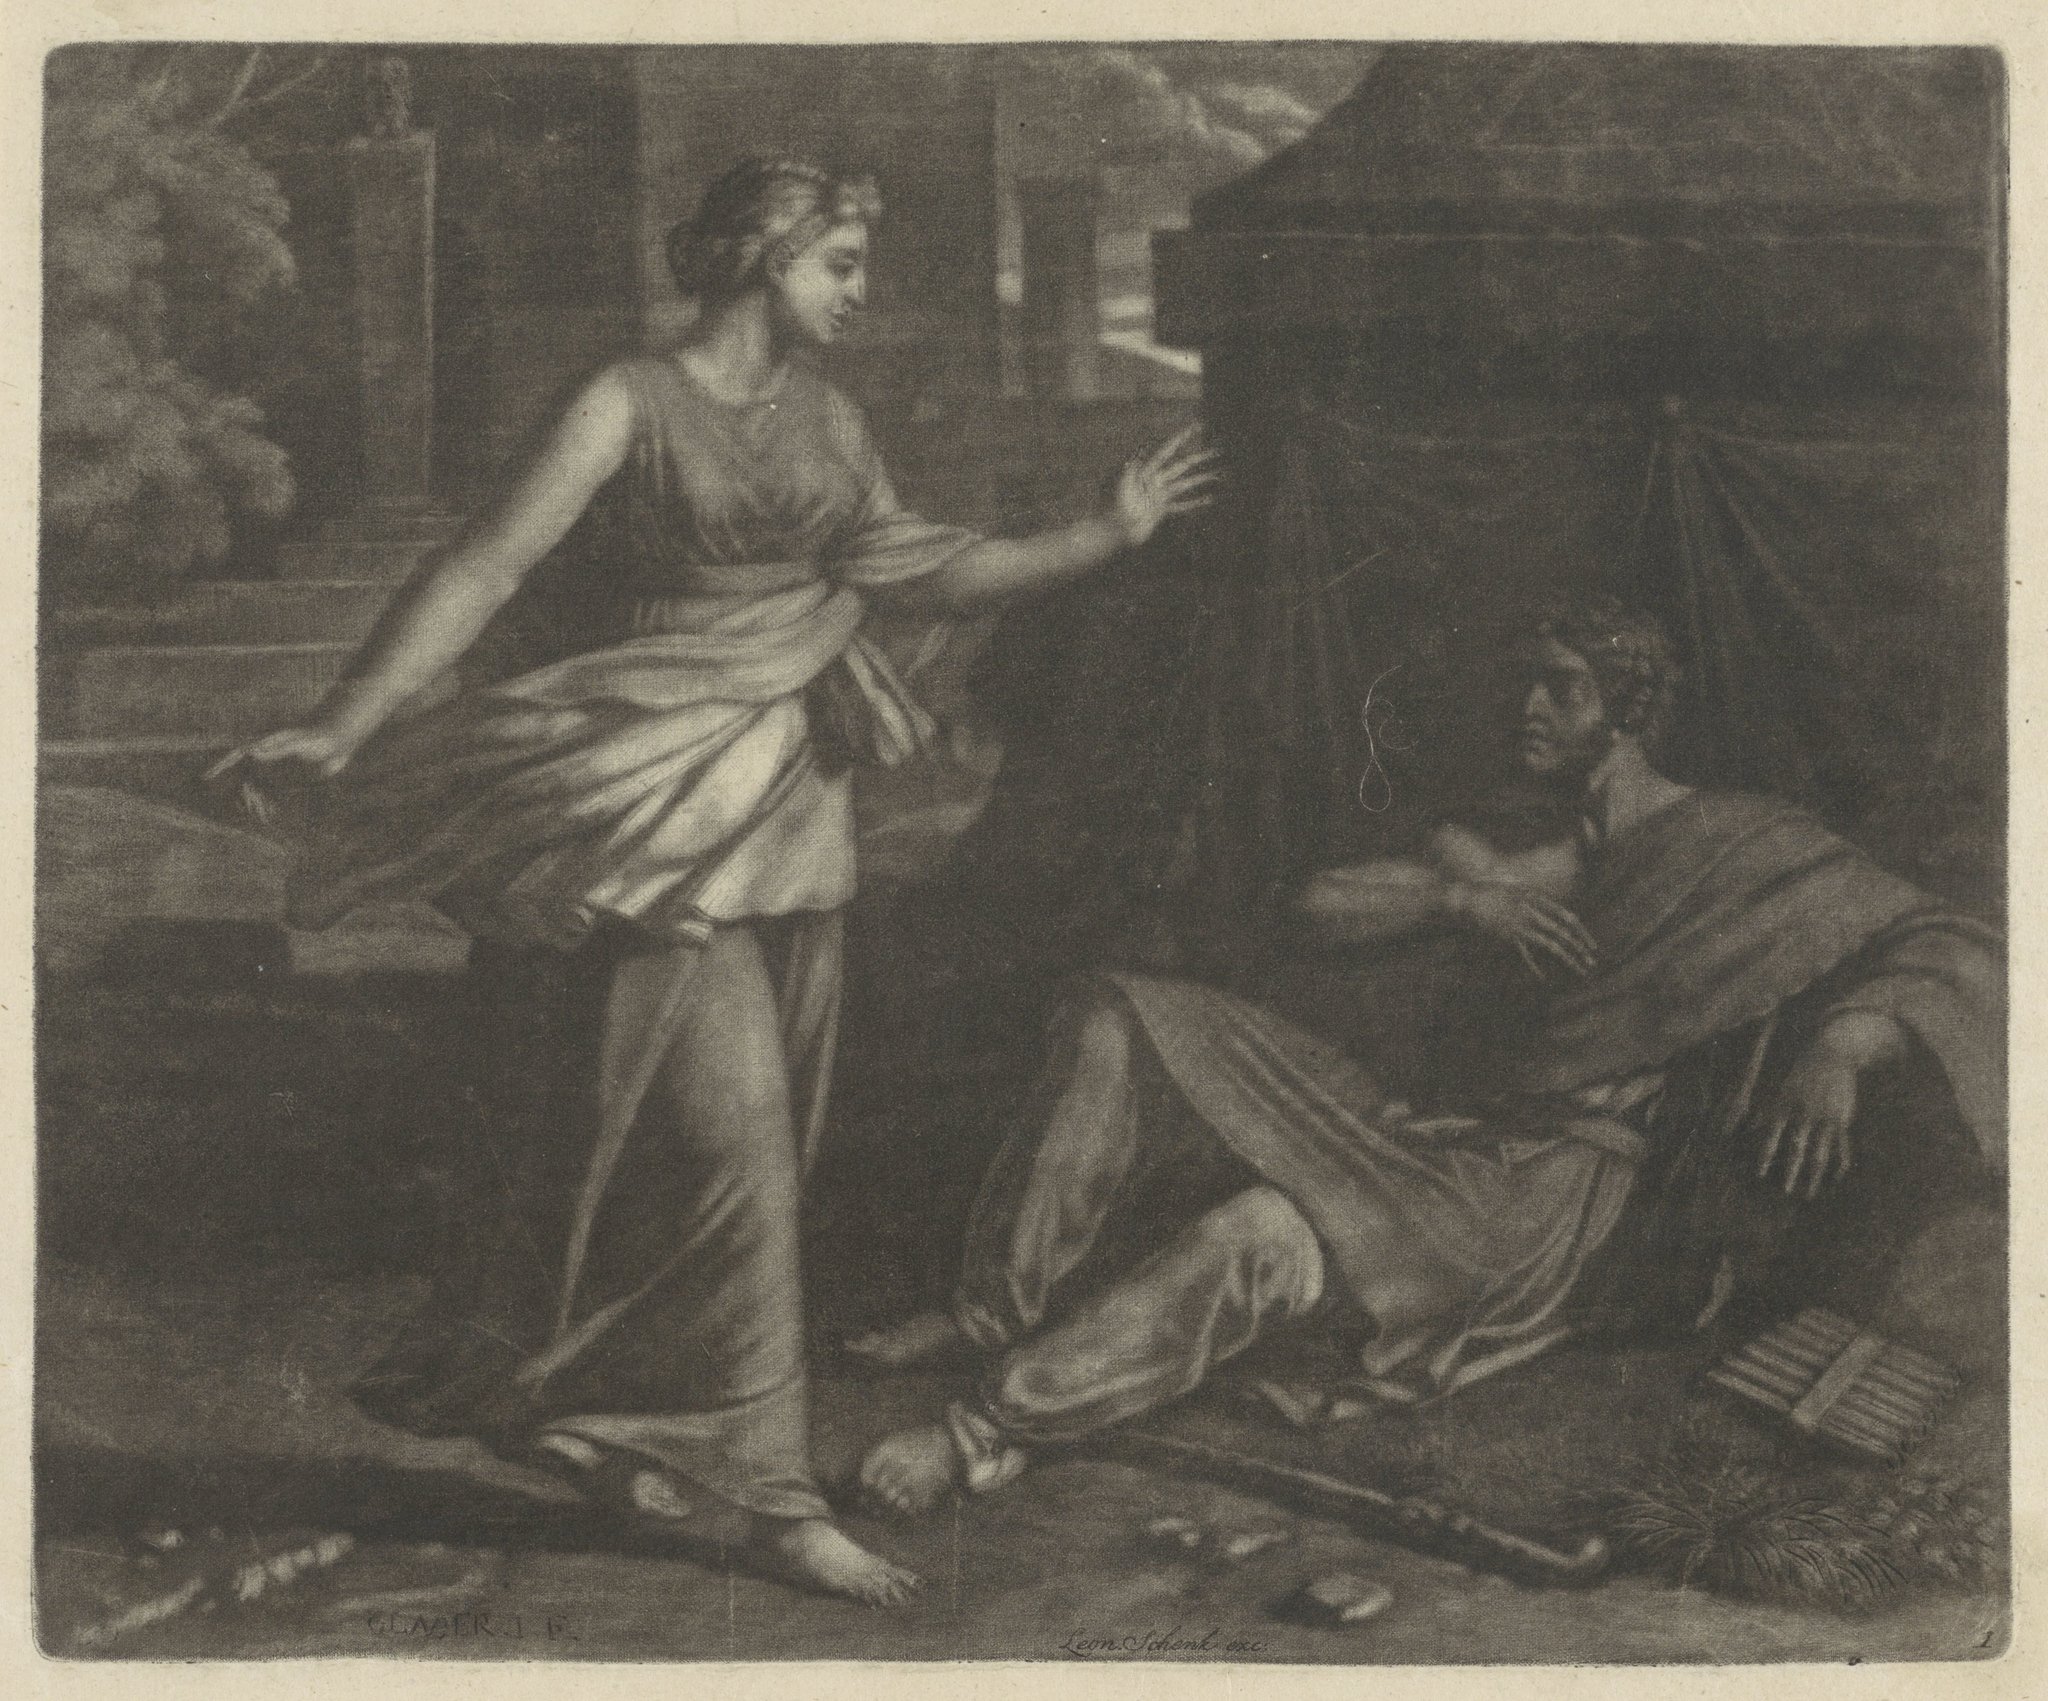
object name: print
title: Herder en een vrouw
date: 1656-1726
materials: paper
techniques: engraving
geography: amsterdam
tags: tent, panpipes, herding, herdsman, herdswoman, shepherd, shepherdess, cowherd, etc.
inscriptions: collector's mark: Lugt 2228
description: Landschap met een vrouw die langs een herder loopt die voor een tent ligt. Naast hem zijn herdersstaf en een panfluit.